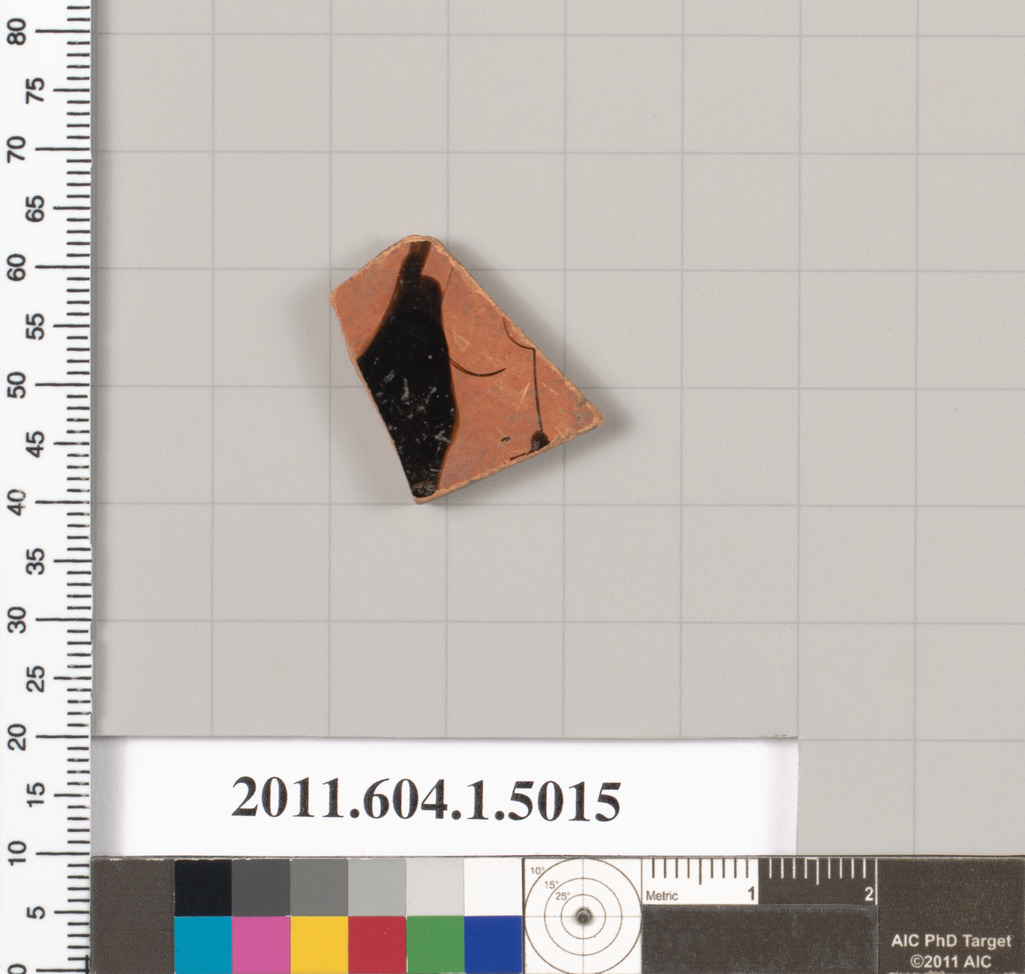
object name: kylix fragment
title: Terracotta fragment of a kylix (drinking cup)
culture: greek, attic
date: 467-435 BCE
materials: terracotta